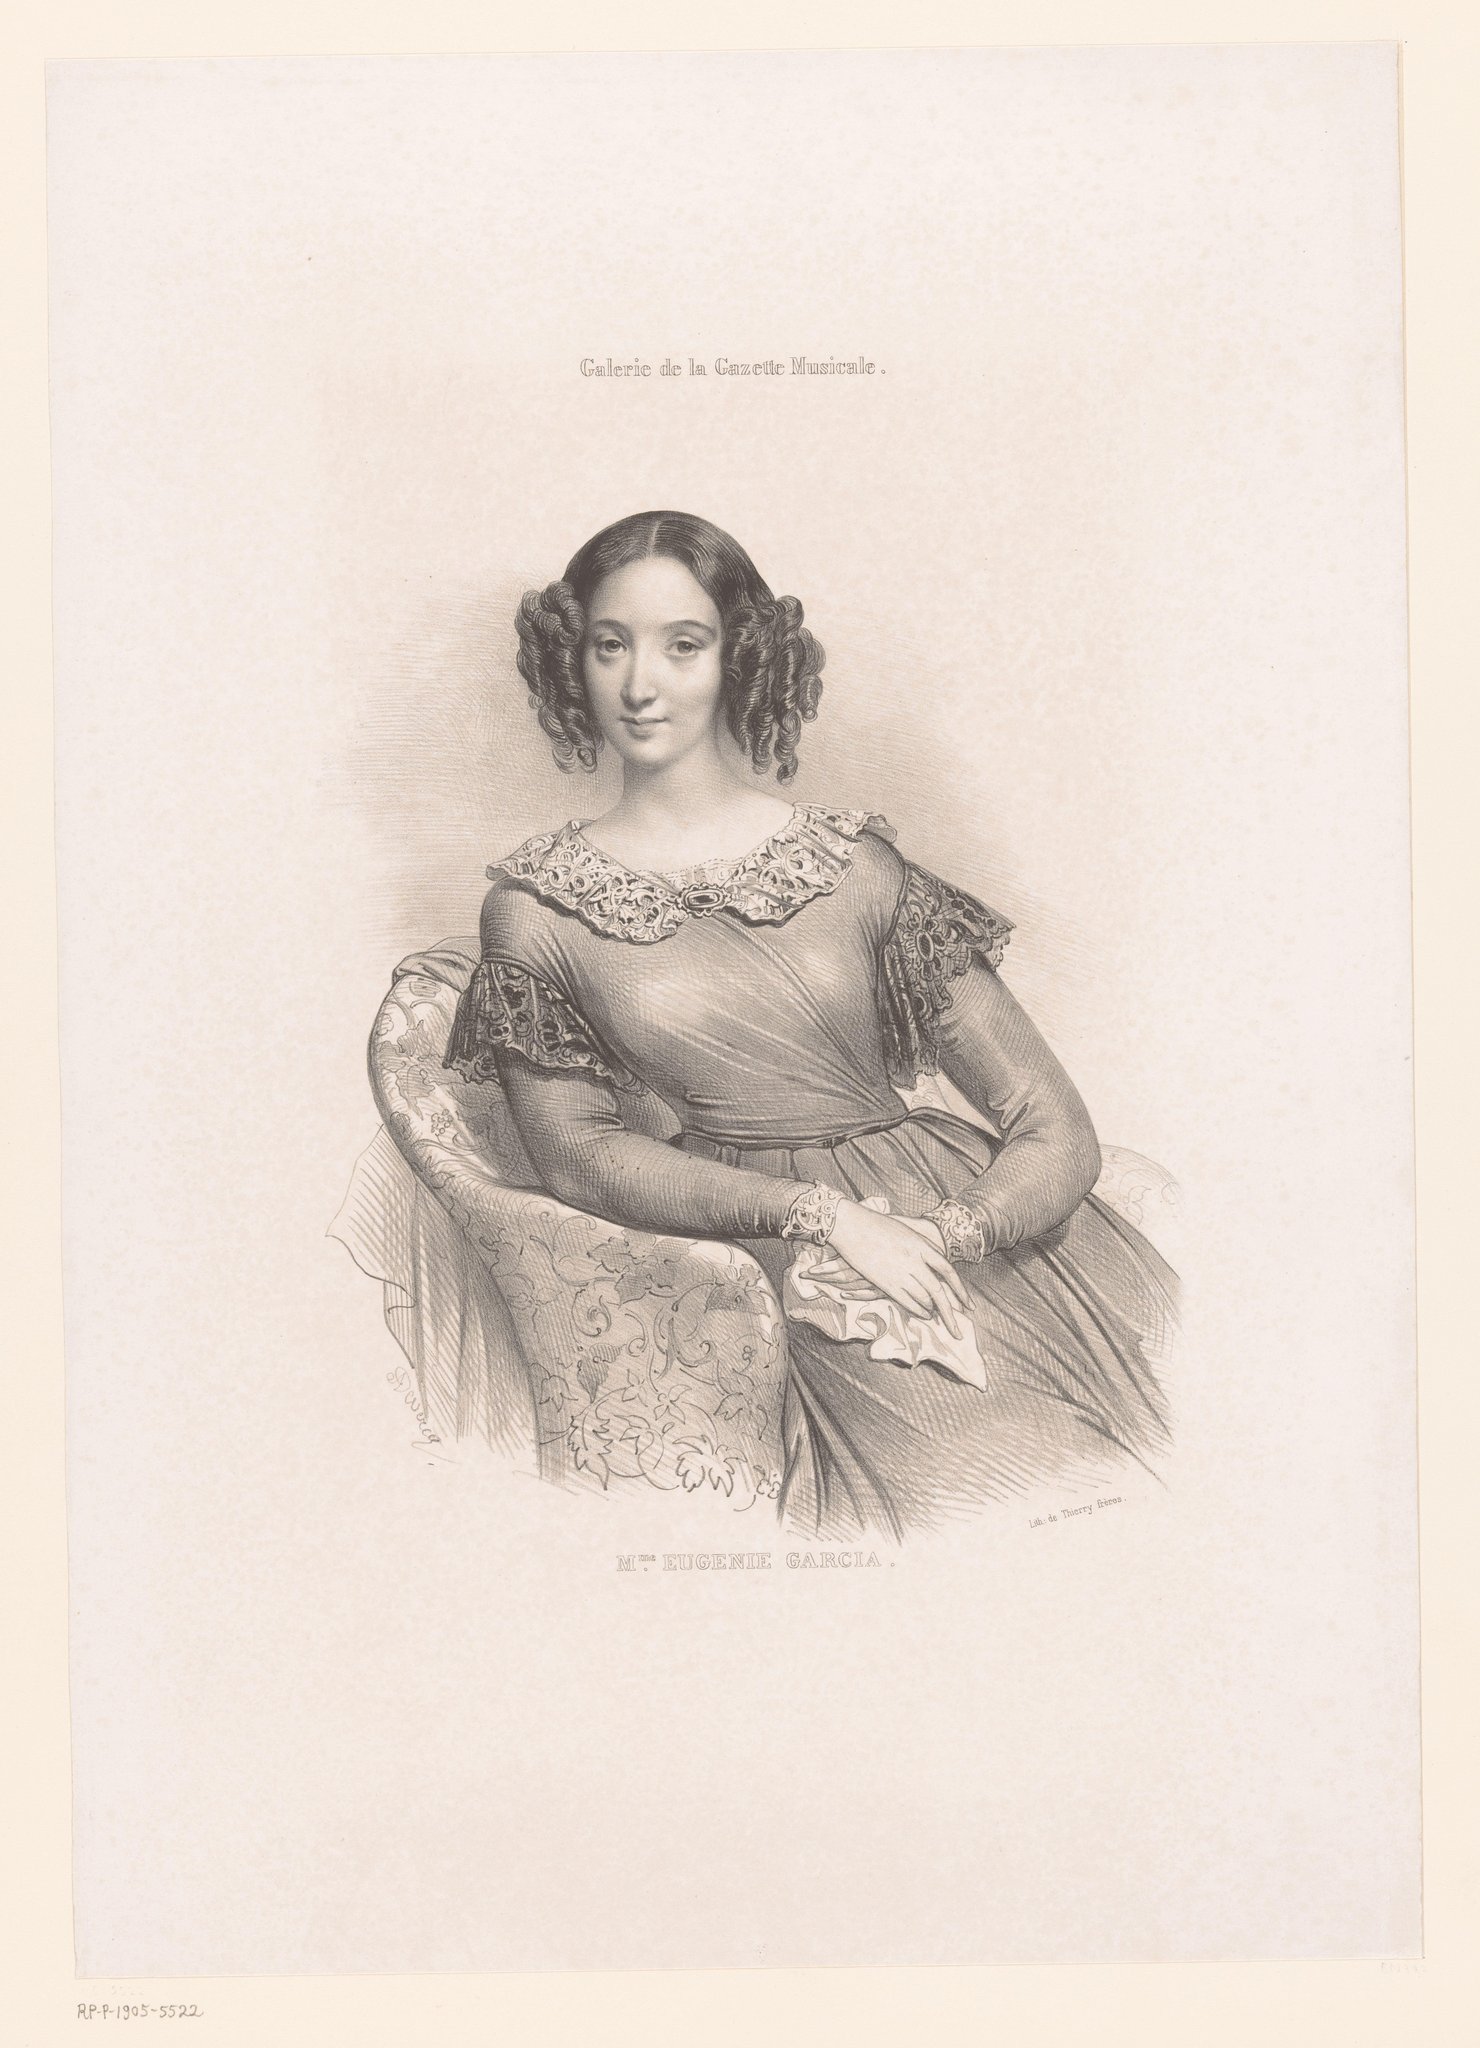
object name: print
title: Portret van de zangeres Eugénie Garcia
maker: achille devéria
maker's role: draughtsman, painter, print maker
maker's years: 1800-1857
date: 1840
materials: paper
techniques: lithograph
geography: paris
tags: historical persons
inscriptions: collector's mark: Lugt 2228a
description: Prent gebruikt voor: Galerie de la Gazette Musicale.